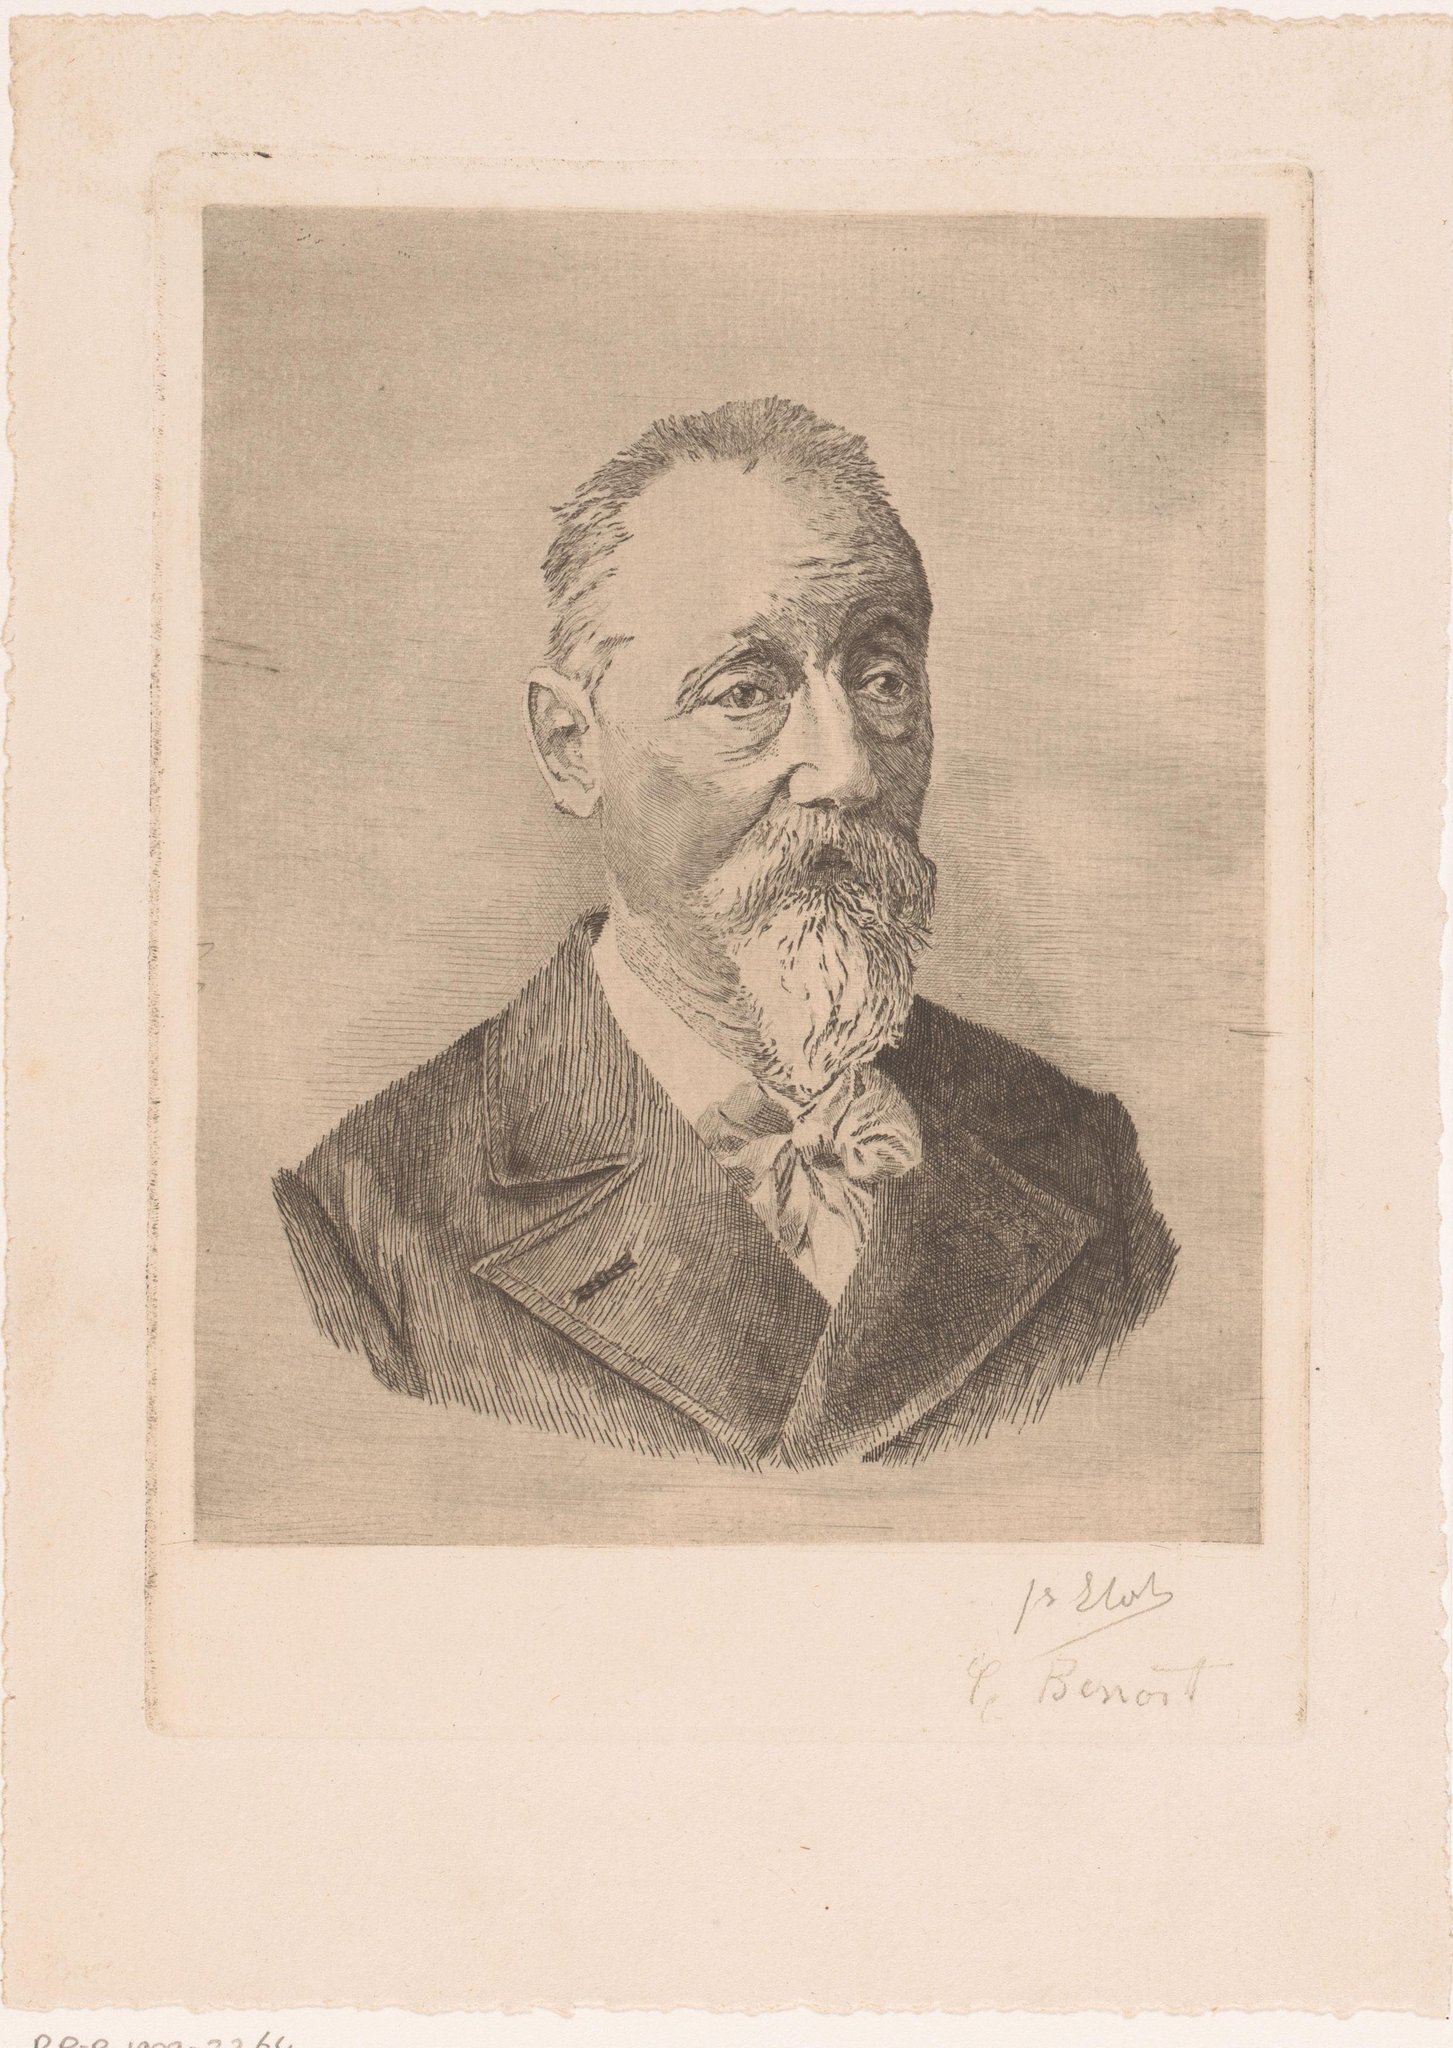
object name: print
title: Portret van een onbekende oudere man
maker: clément benoit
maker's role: draughtsman, painter, print maker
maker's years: 1866-1953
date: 1876-1909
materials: paper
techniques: etching, intaglio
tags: historical persons, old man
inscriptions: collector's mark: Lugt 2228